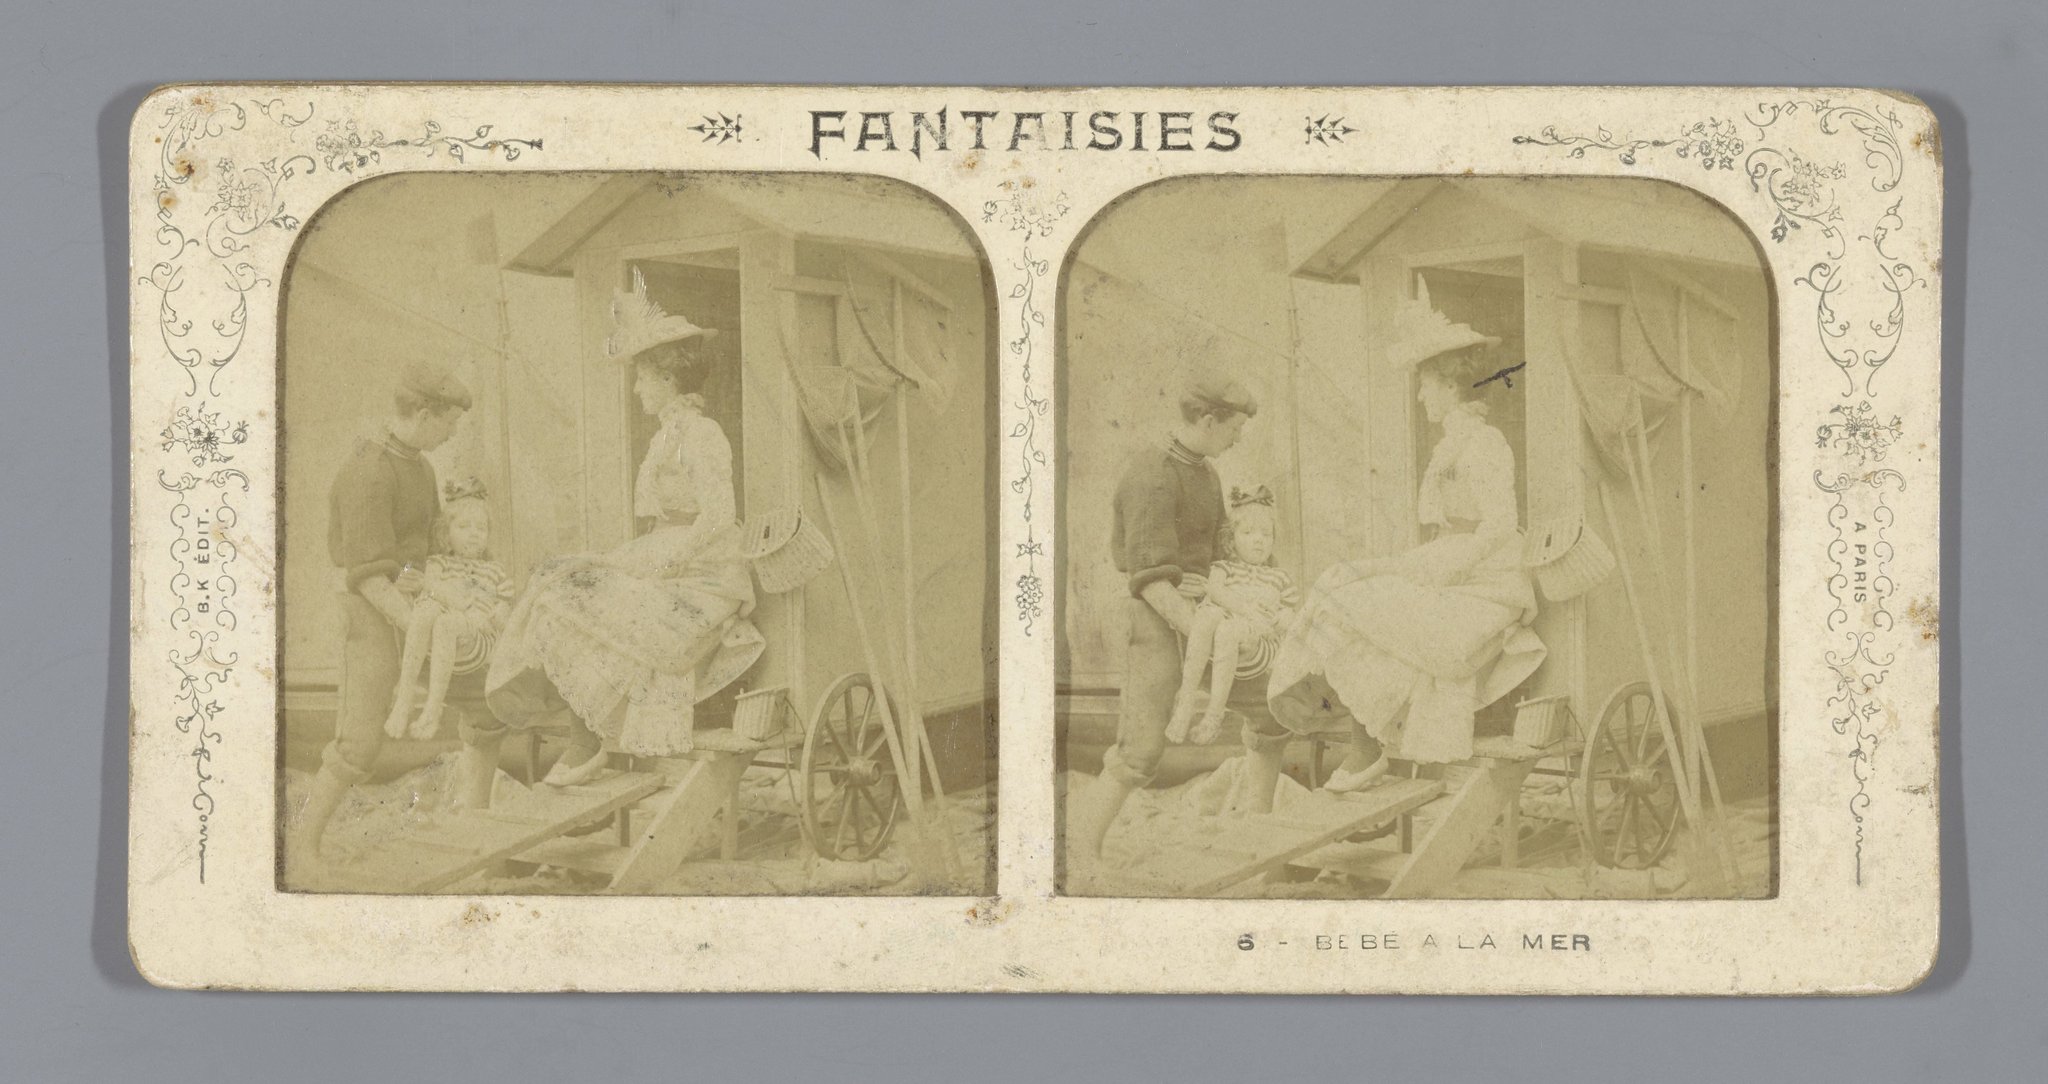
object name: tissue stereograph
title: Man, vrouw en kind aan zee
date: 1863-1875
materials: cardboard, paper, photographic support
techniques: albumen print, cutting, hand coloring, perforating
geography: paris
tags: adult woman, adult man, girl (child between toddler and youth), beach, france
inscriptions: number: ‘6’